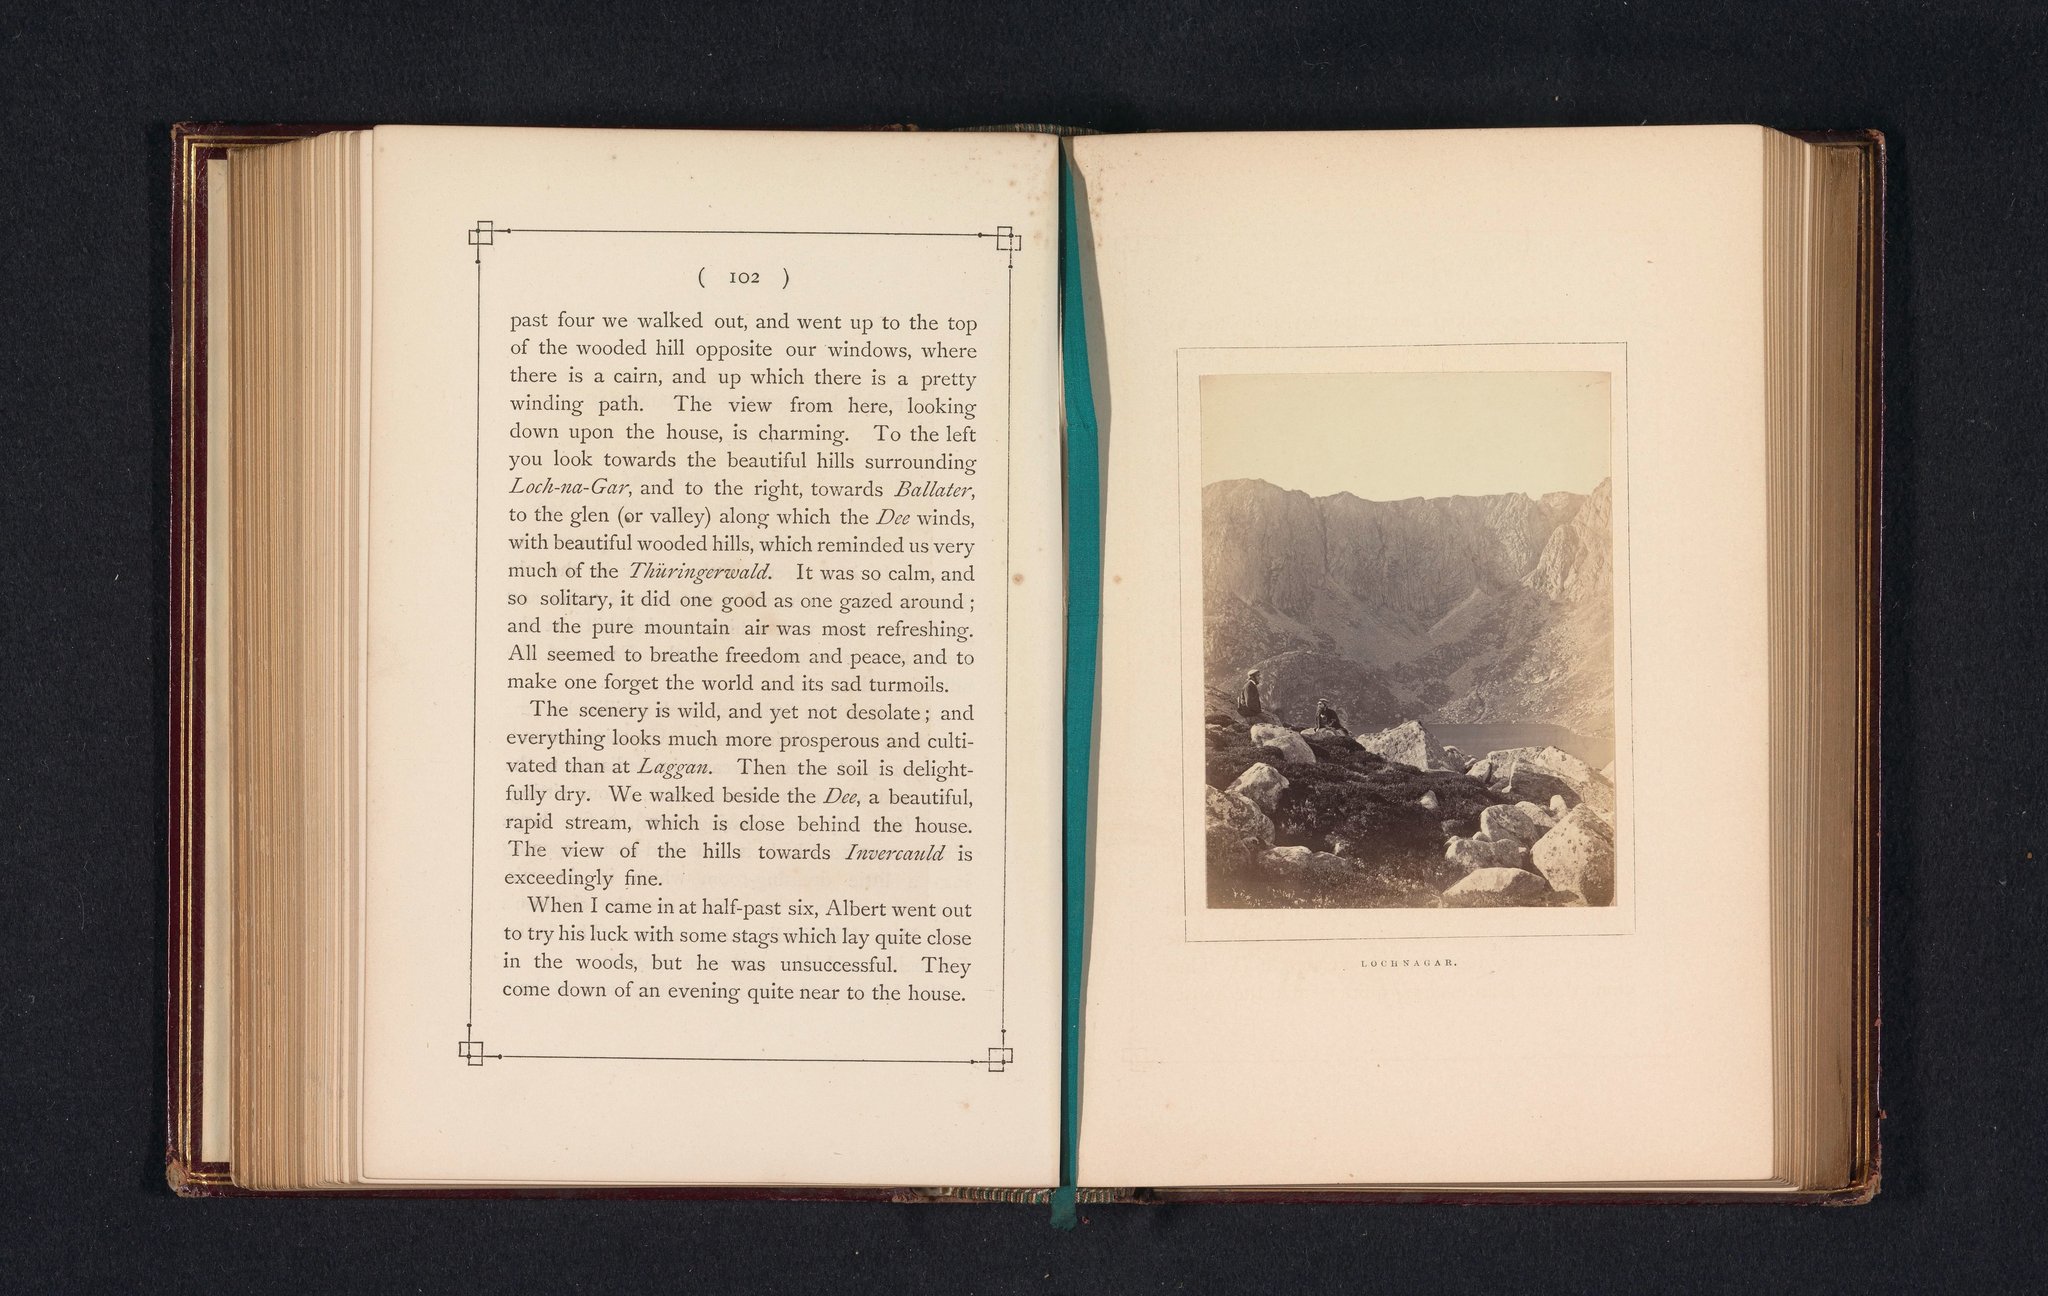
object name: photograph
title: Gezicht op de Lochnagar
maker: george washington wilson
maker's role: publisher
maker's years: 1823-1893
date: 1858-1868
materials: photographic support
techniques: albumen print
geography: scotland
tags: lake, mountains